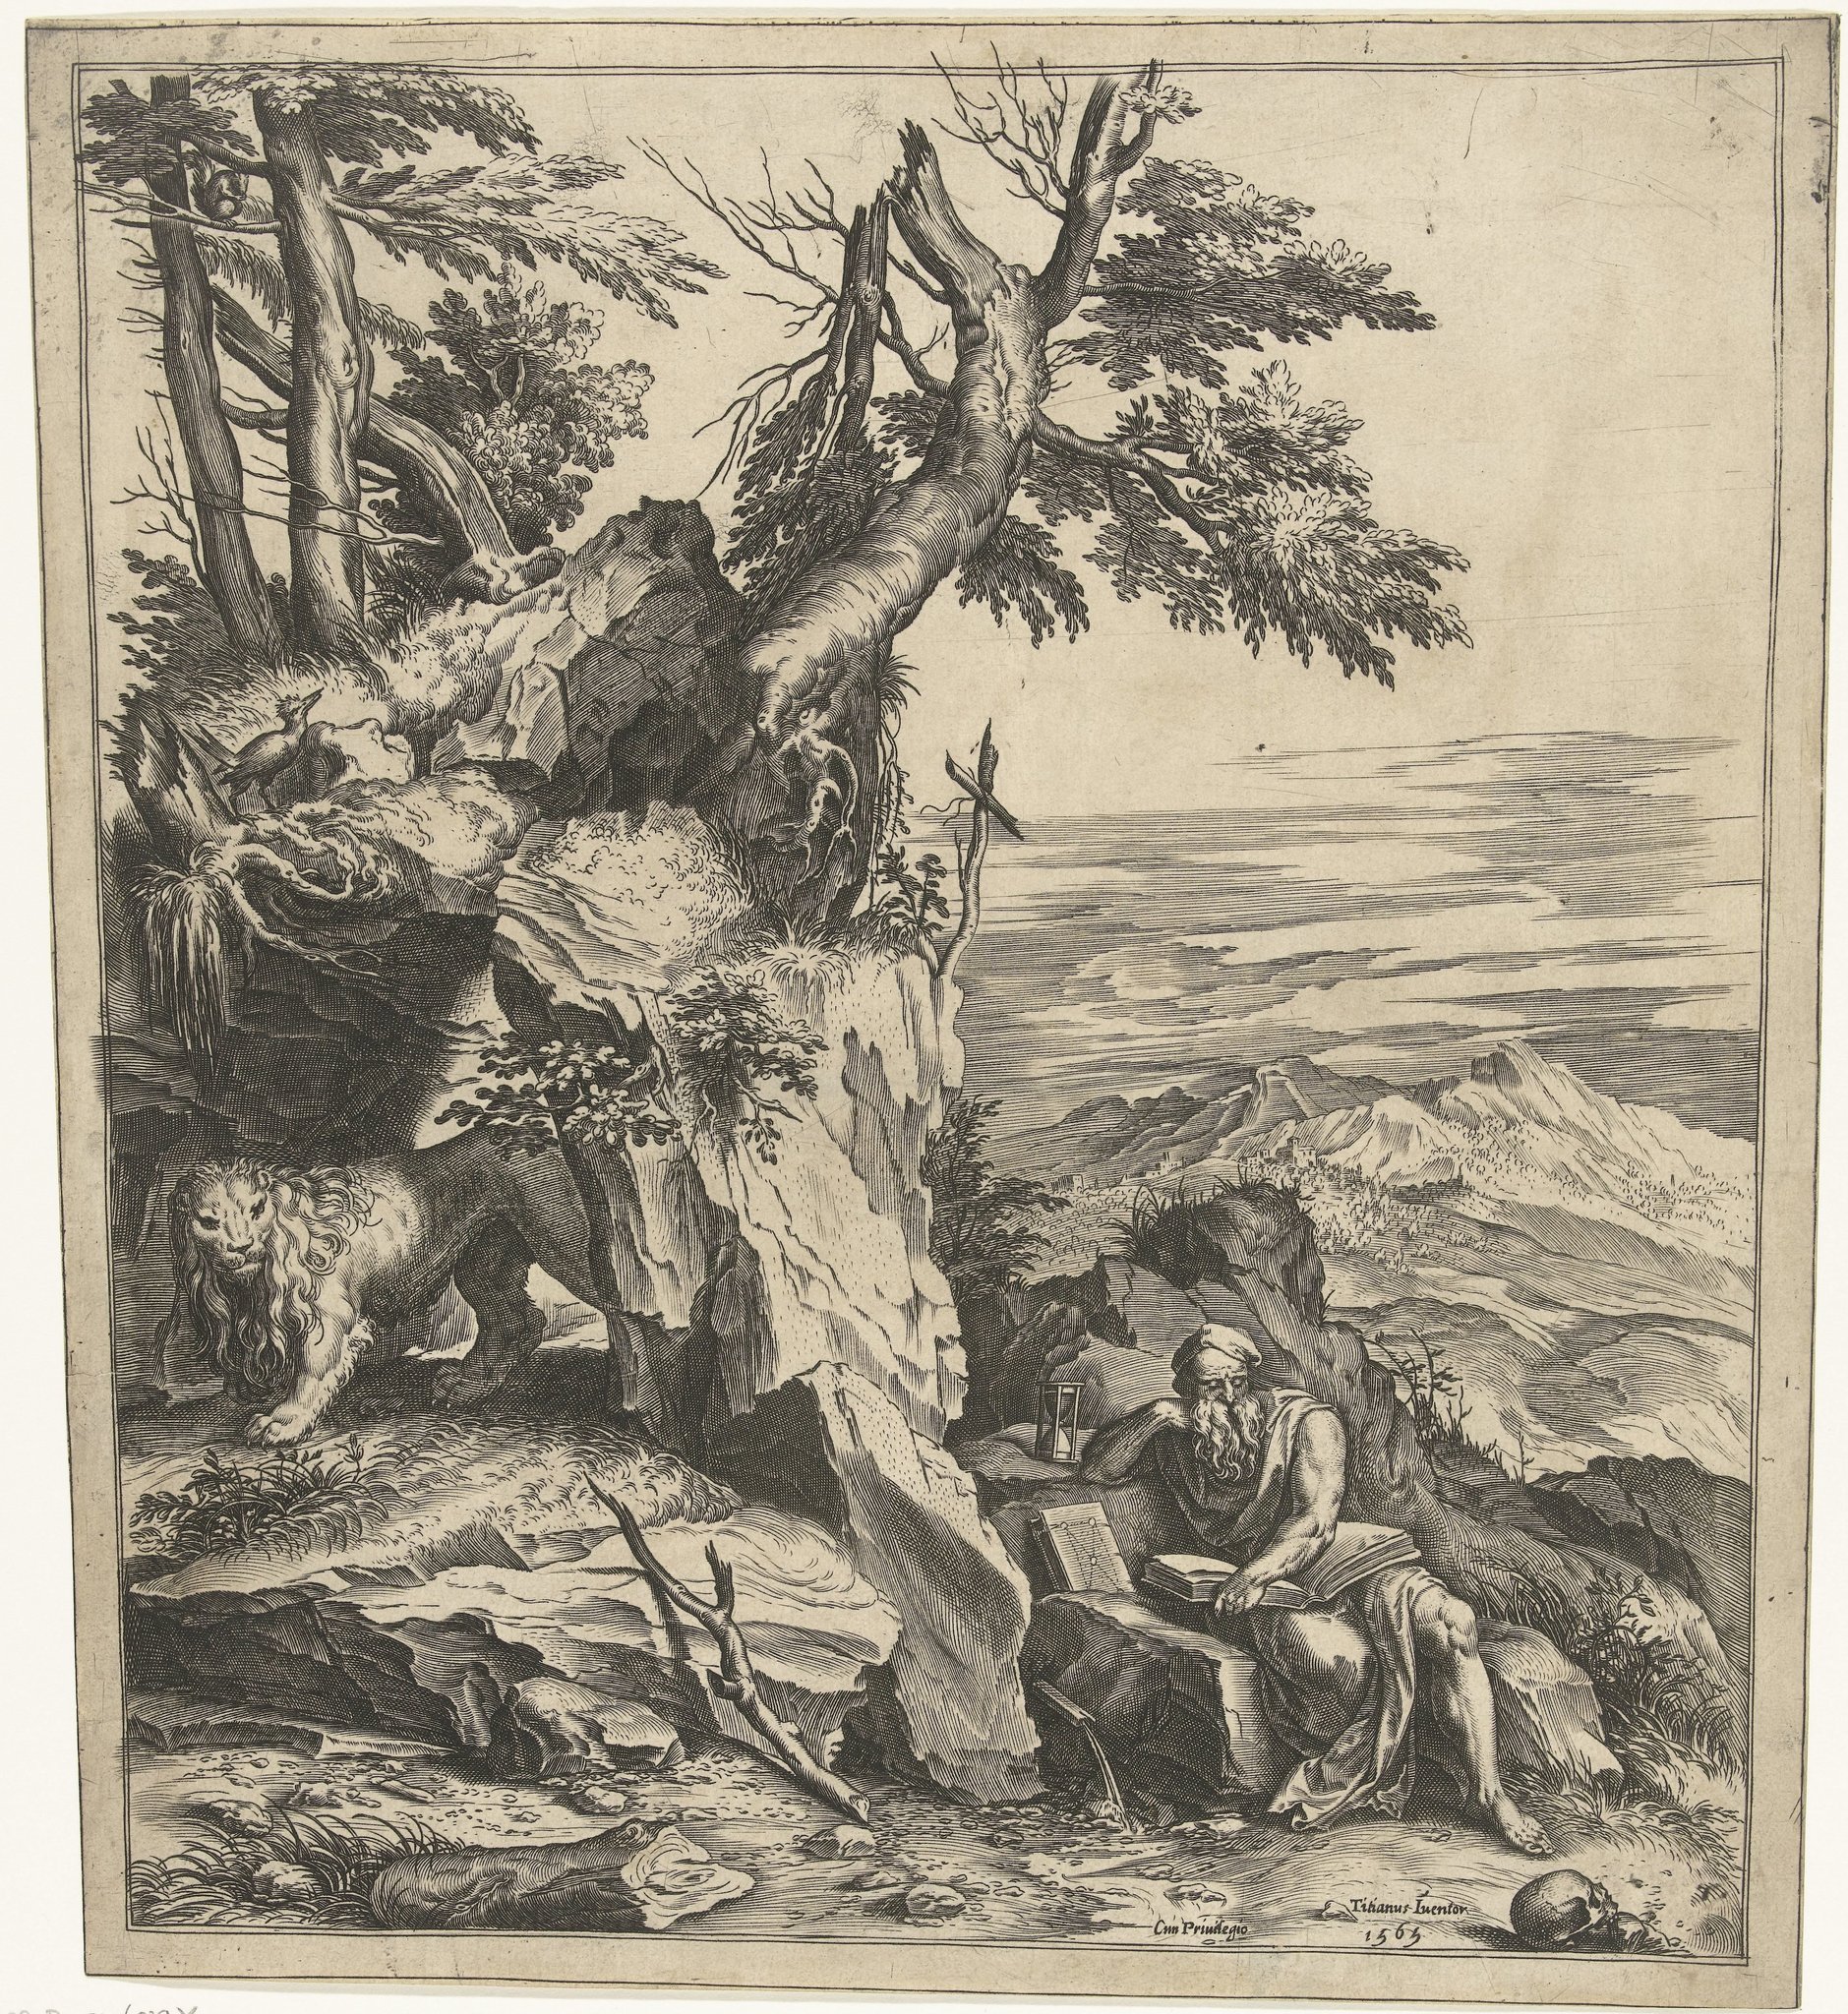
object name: print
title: Landschap met lezende Hieronymus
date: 1565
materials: paper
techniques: engraving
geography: rome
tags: the monk and hermit jerome (hieronymus); possible attributes: book, cardinal's hat, crucifix, hour-glass, lion, skull, stone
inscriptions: collector's mark: Lugt 240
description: De heilige Hieronymus zit in een bergachtig landschap op een rots te lezen. Naast hem een boek en een zandloper. De leeuw, zijn attribuut, struint tussen de rotsen.